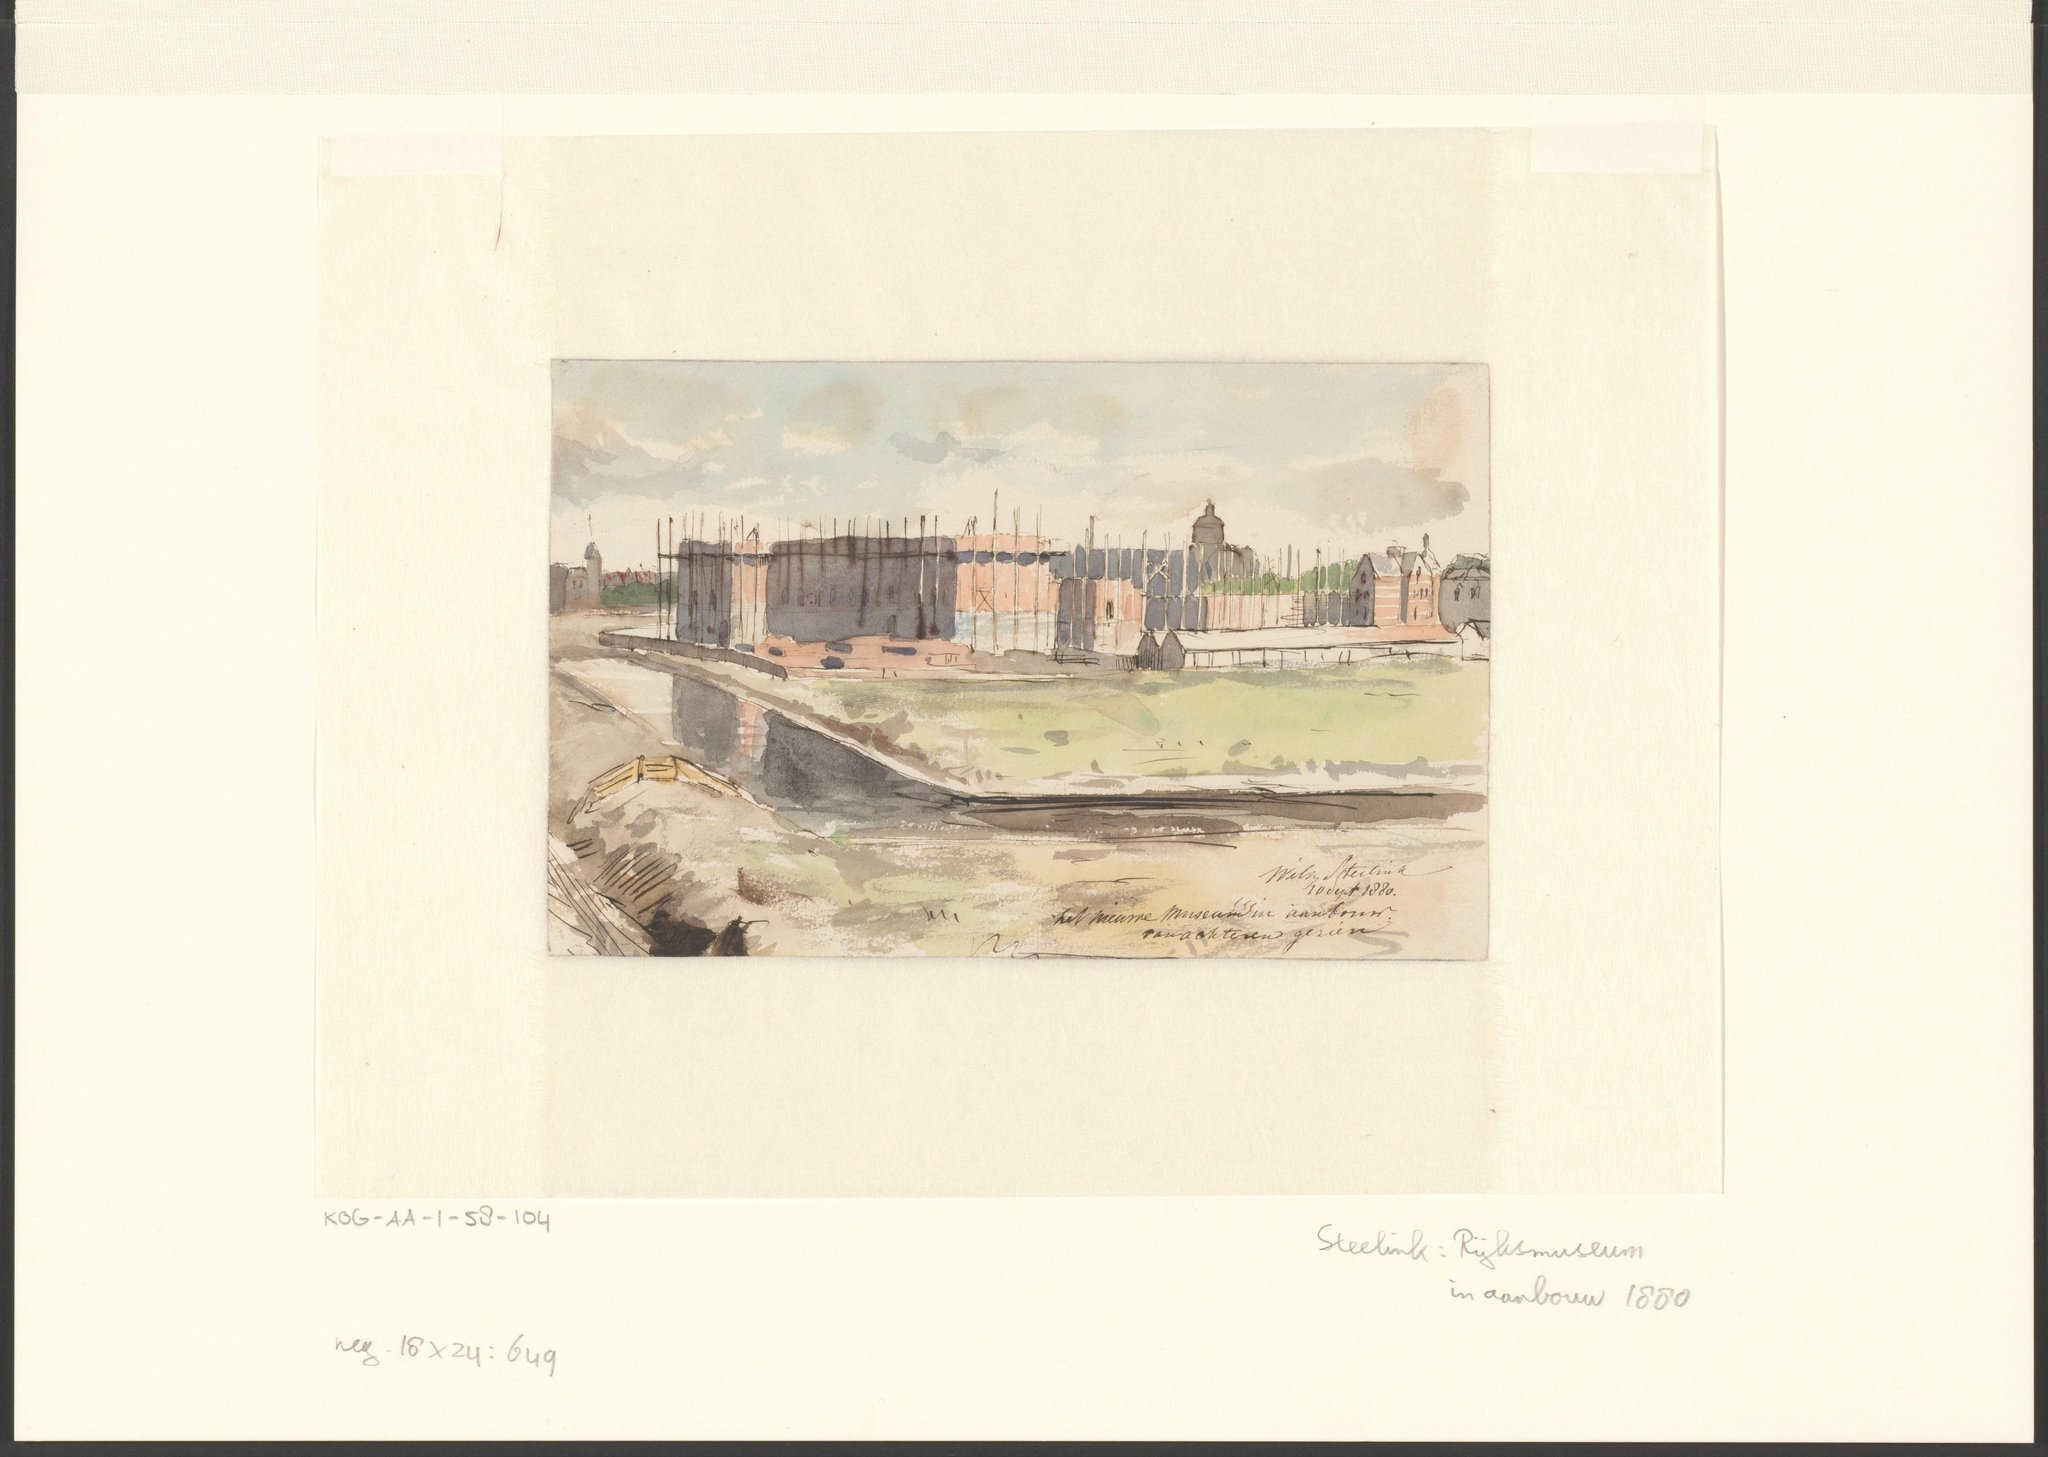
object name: drawing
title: Gezicht op het Rijksmuseum in aanbouw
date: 1880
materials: ink, paper, watercolor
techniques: brush, pen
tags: city-view in general; 'veduta', permanent exhibition, museum, building-site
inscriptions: signature, date and inscription: ‘Willy Steelink / 10 (...) van achteren gezien’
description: Onderwerpsrubriek binnen de Atlas Amsterdam: Rijksmuseum.